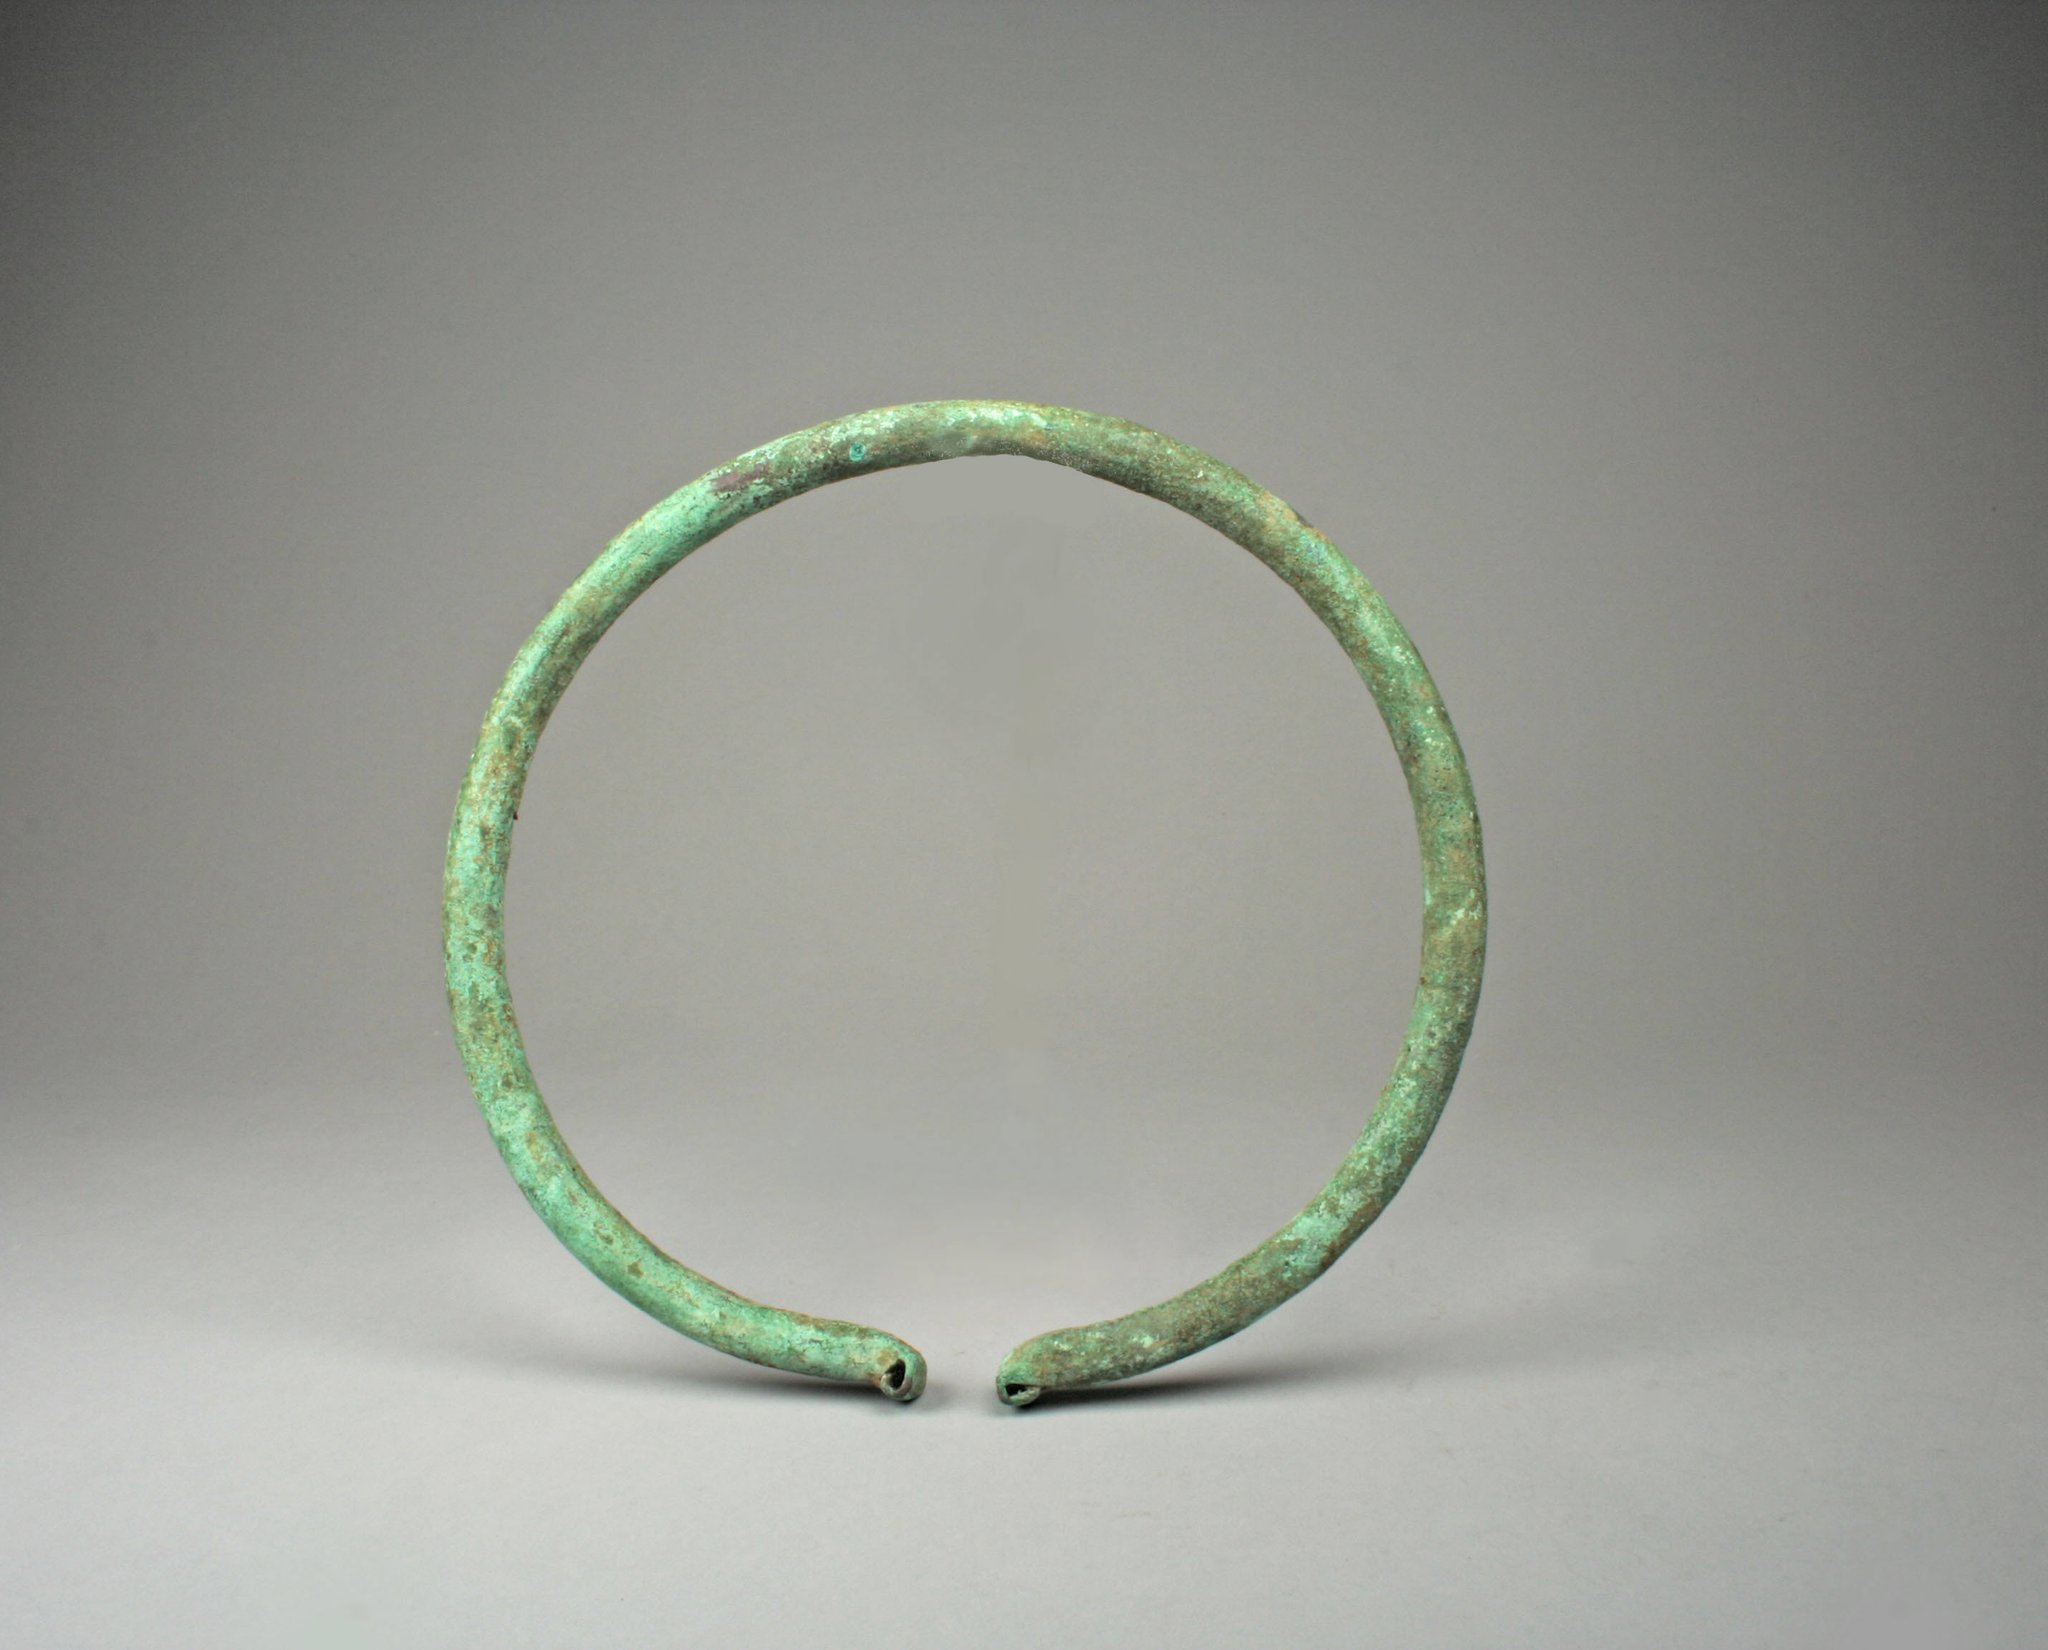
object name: necklace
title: Torque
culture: bura peoples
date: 201-1100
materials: copper alloy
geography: niger